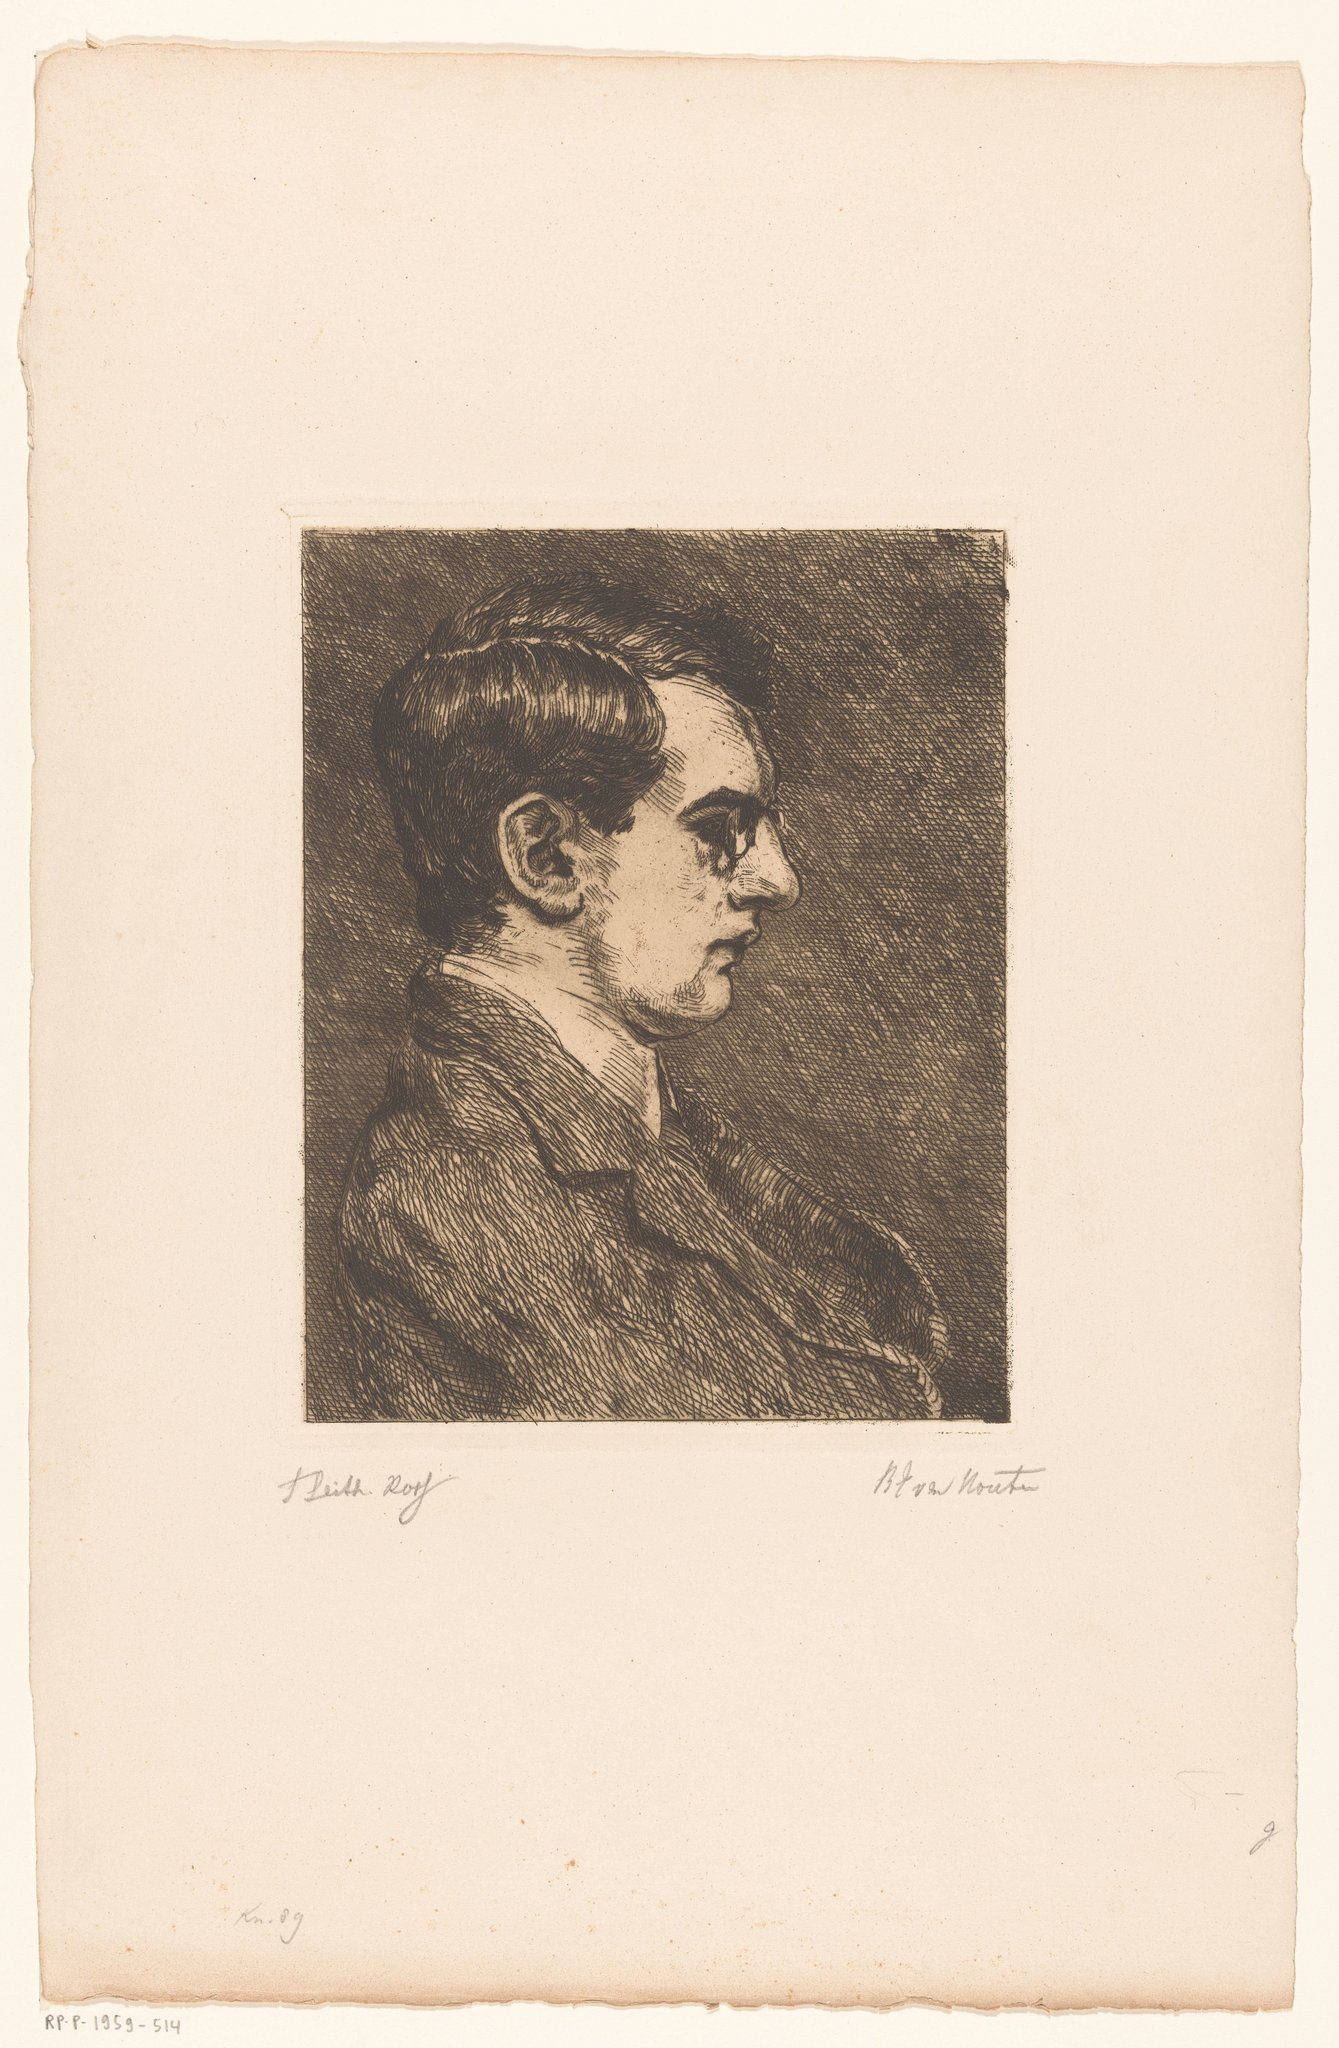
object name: print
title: Portret van Frederick Leith-Ross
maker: barbara elisabeth van houten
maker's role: draughtsman, print maker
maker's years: 1862-1950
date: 1872-1950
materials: paper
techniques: etching, intaglio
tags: eyeglasses, spectacles, historical persons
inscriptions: collector's mark: Lugt 2228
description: Frederick Leith-Ross was een zoon van Sina van Houten, één van de zussen van Barbara Elisabeth van Houten.